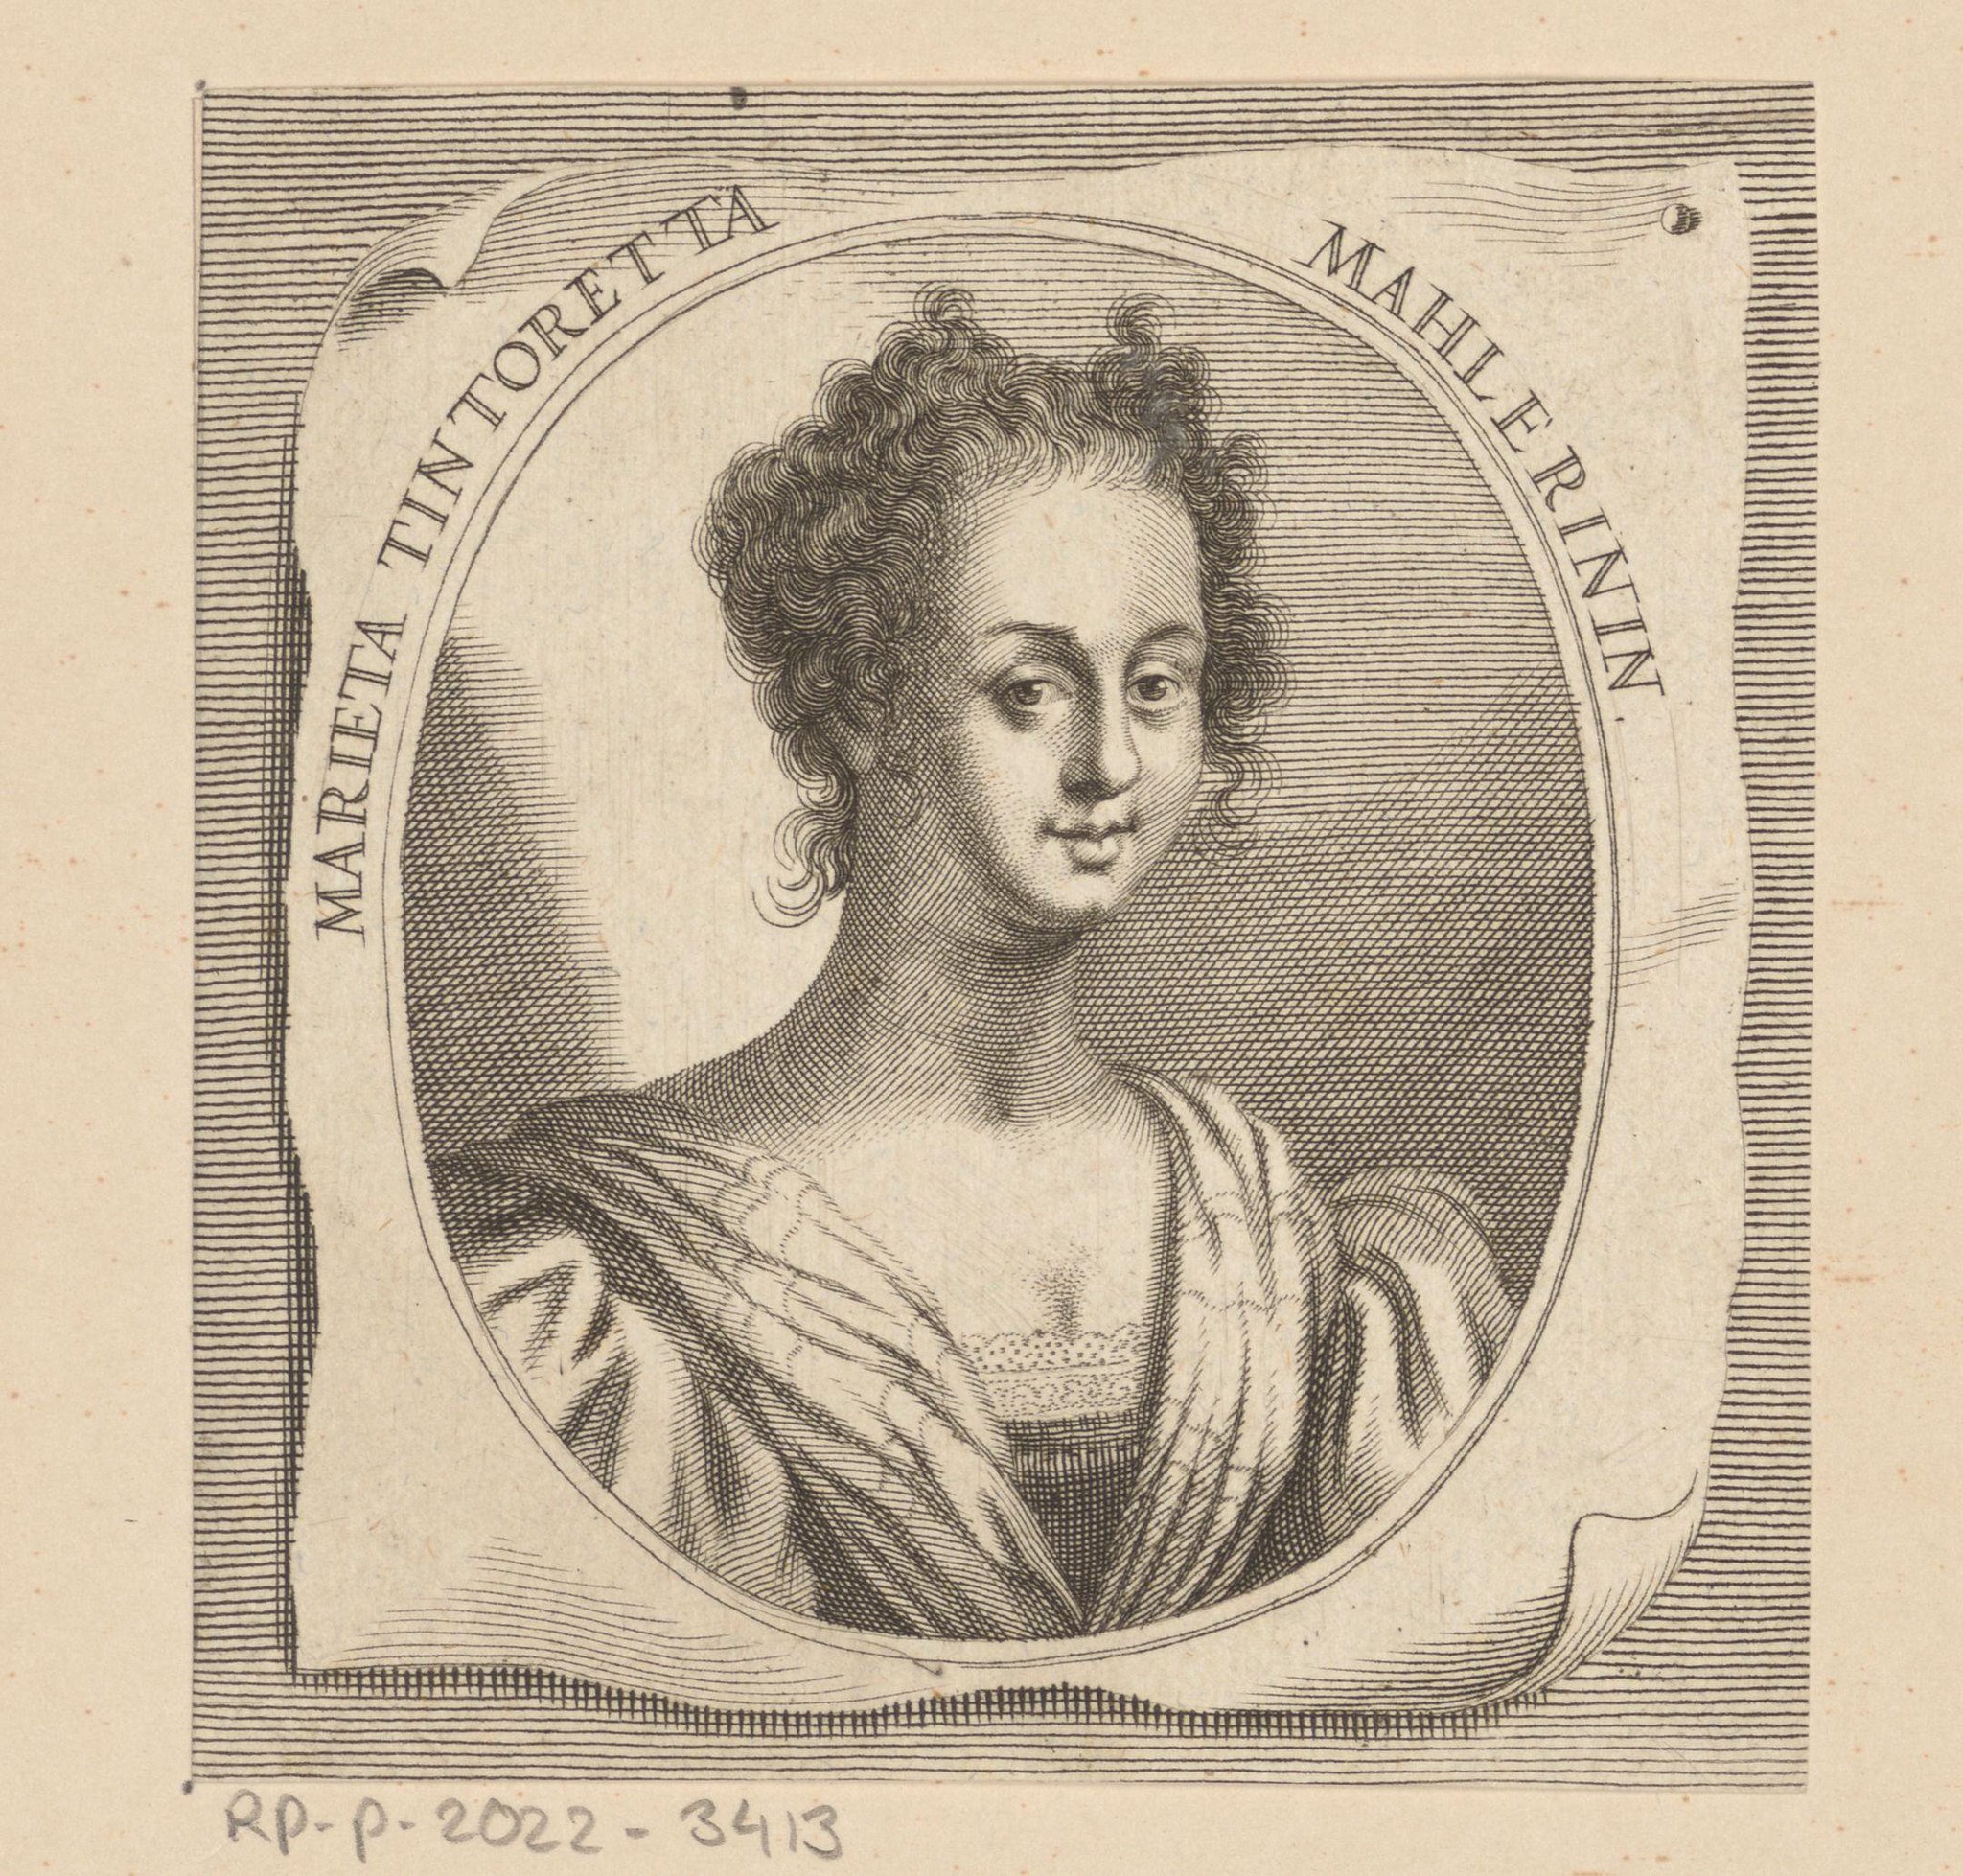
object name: book illustration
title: Portret van Marietta Robusti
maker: philipp kilian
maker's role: print maker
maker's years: 1628-1693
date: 1774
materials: paper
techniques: engraving, etching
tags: venice, painter, marietta robusti, historical persons - bb - woman, portrait, self-portrait of painter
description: Prent waarschijnlijk uit: Sandrart, Joachim von. Teutsche Academie der Bau- Bildhauer- und Maler-Kunst: worinn die Regeln und Lehrsätze dieser Künste gegeben. 14 dln. Neurenberg: erven Johann Andreas Endter, [1774], dl. 7, p. R.